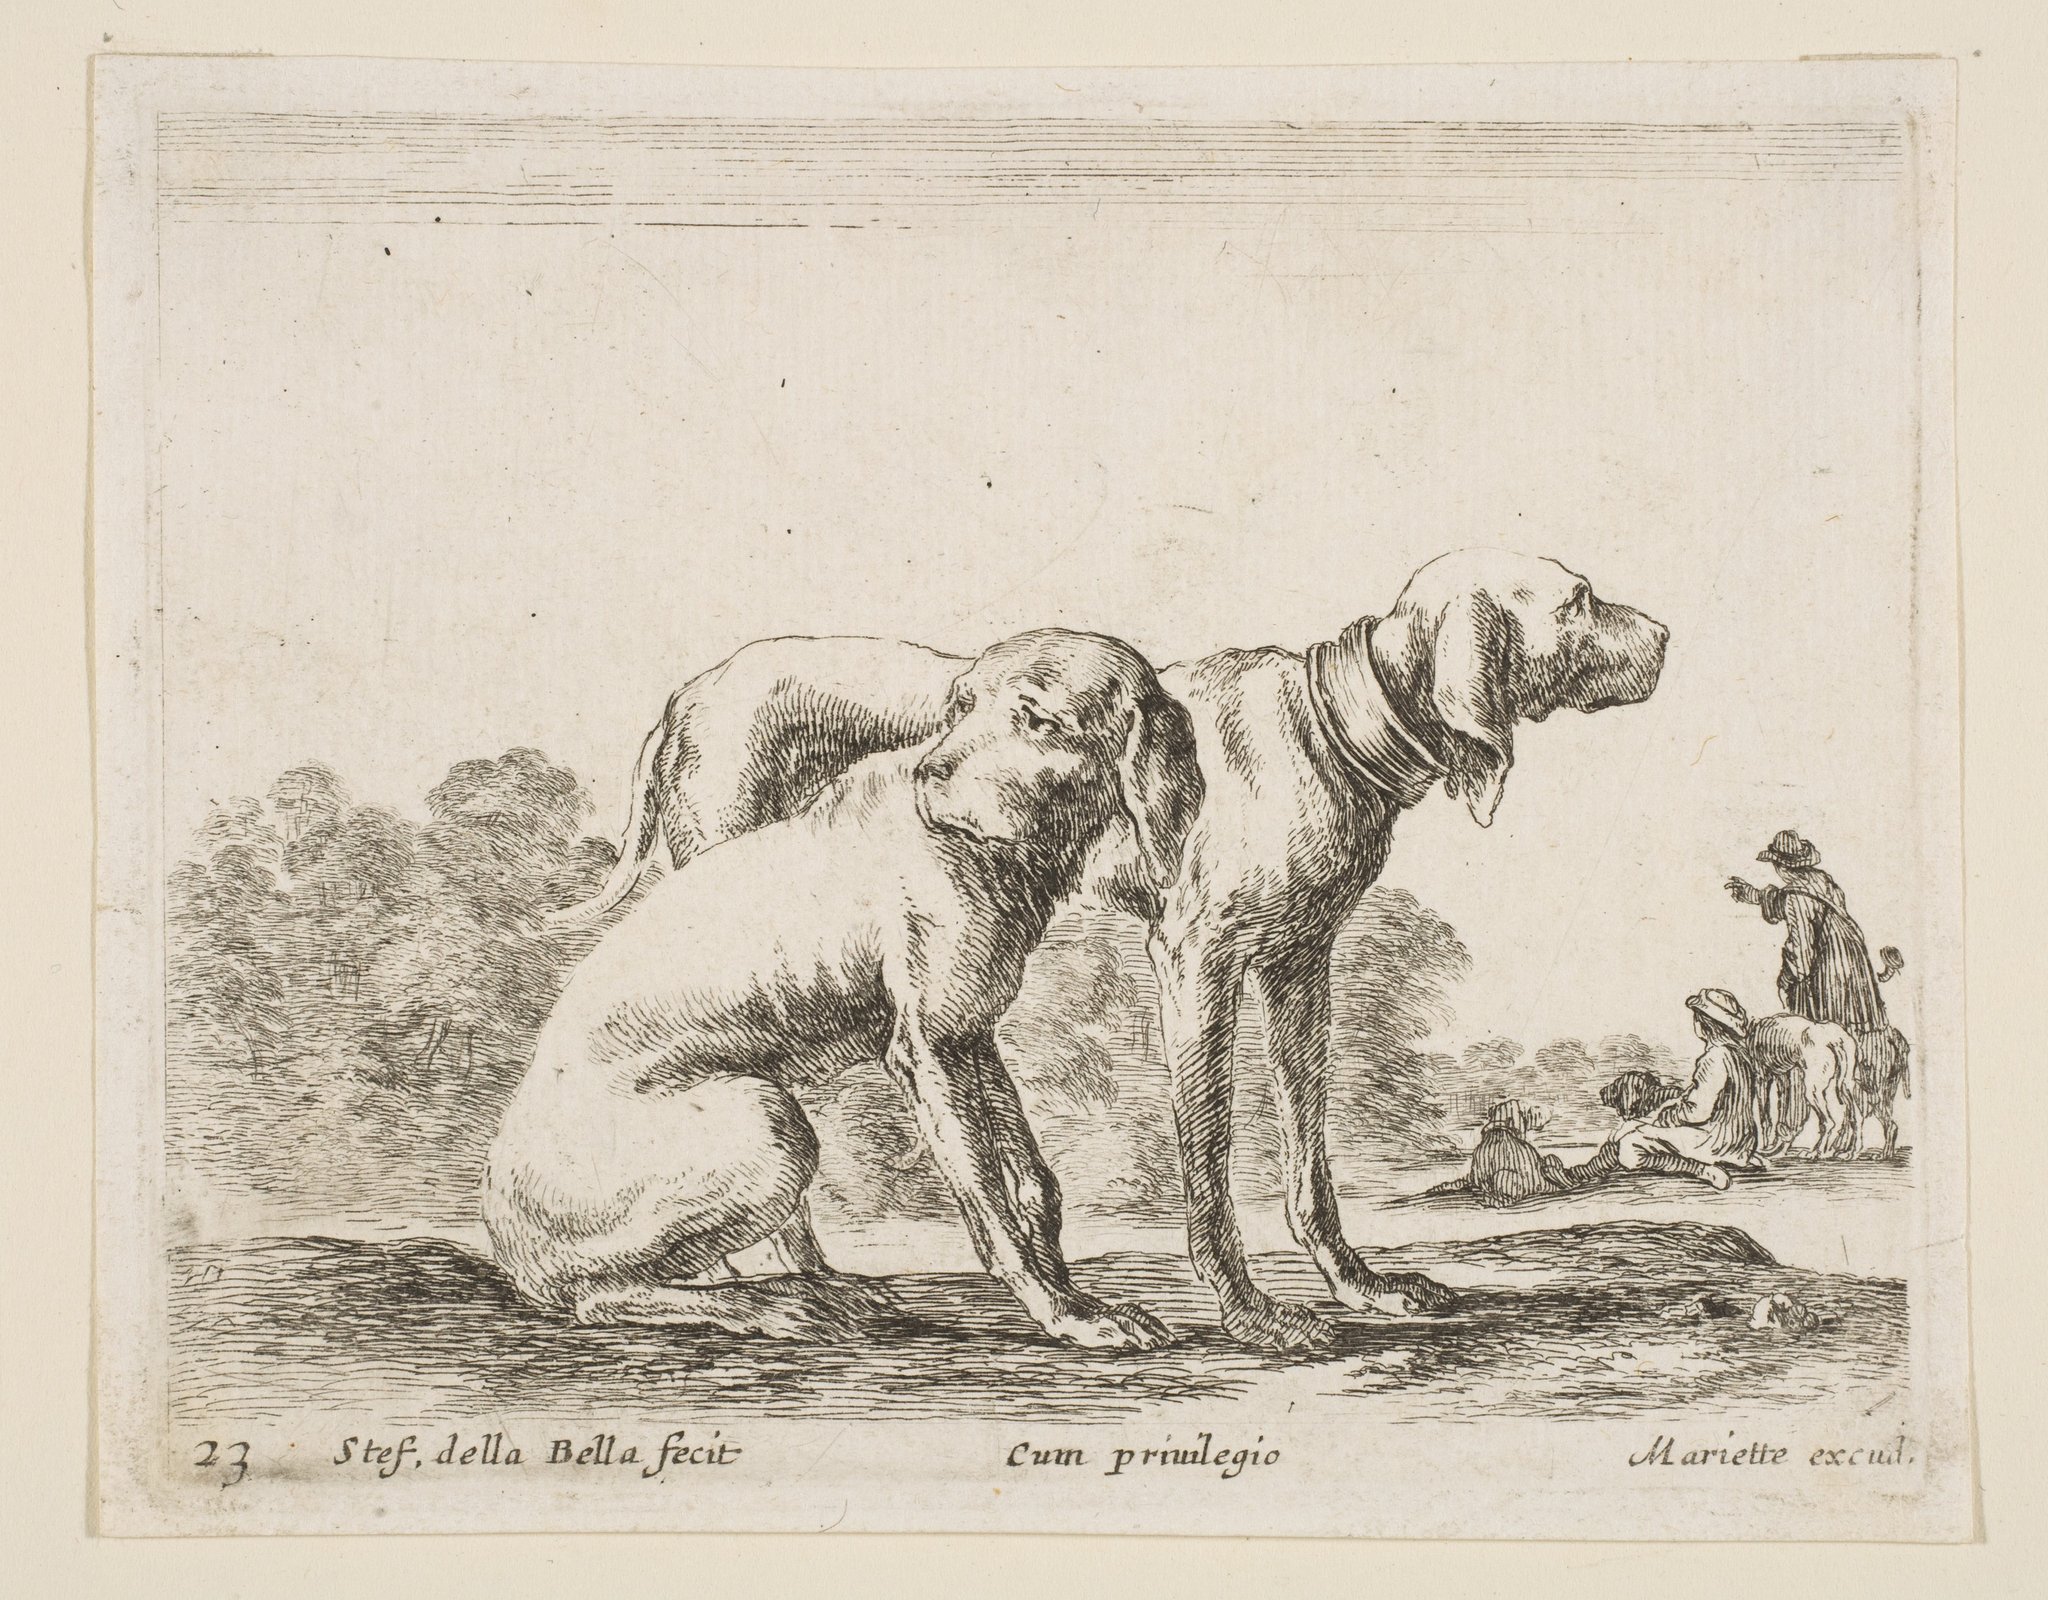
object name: print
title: Two hounds, plate 23 from "Various Animals" (Diversi Animali)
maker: stefano della bella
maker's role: artist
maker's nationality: italian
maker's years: 1610-1664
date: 1641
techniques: etching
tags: dogs